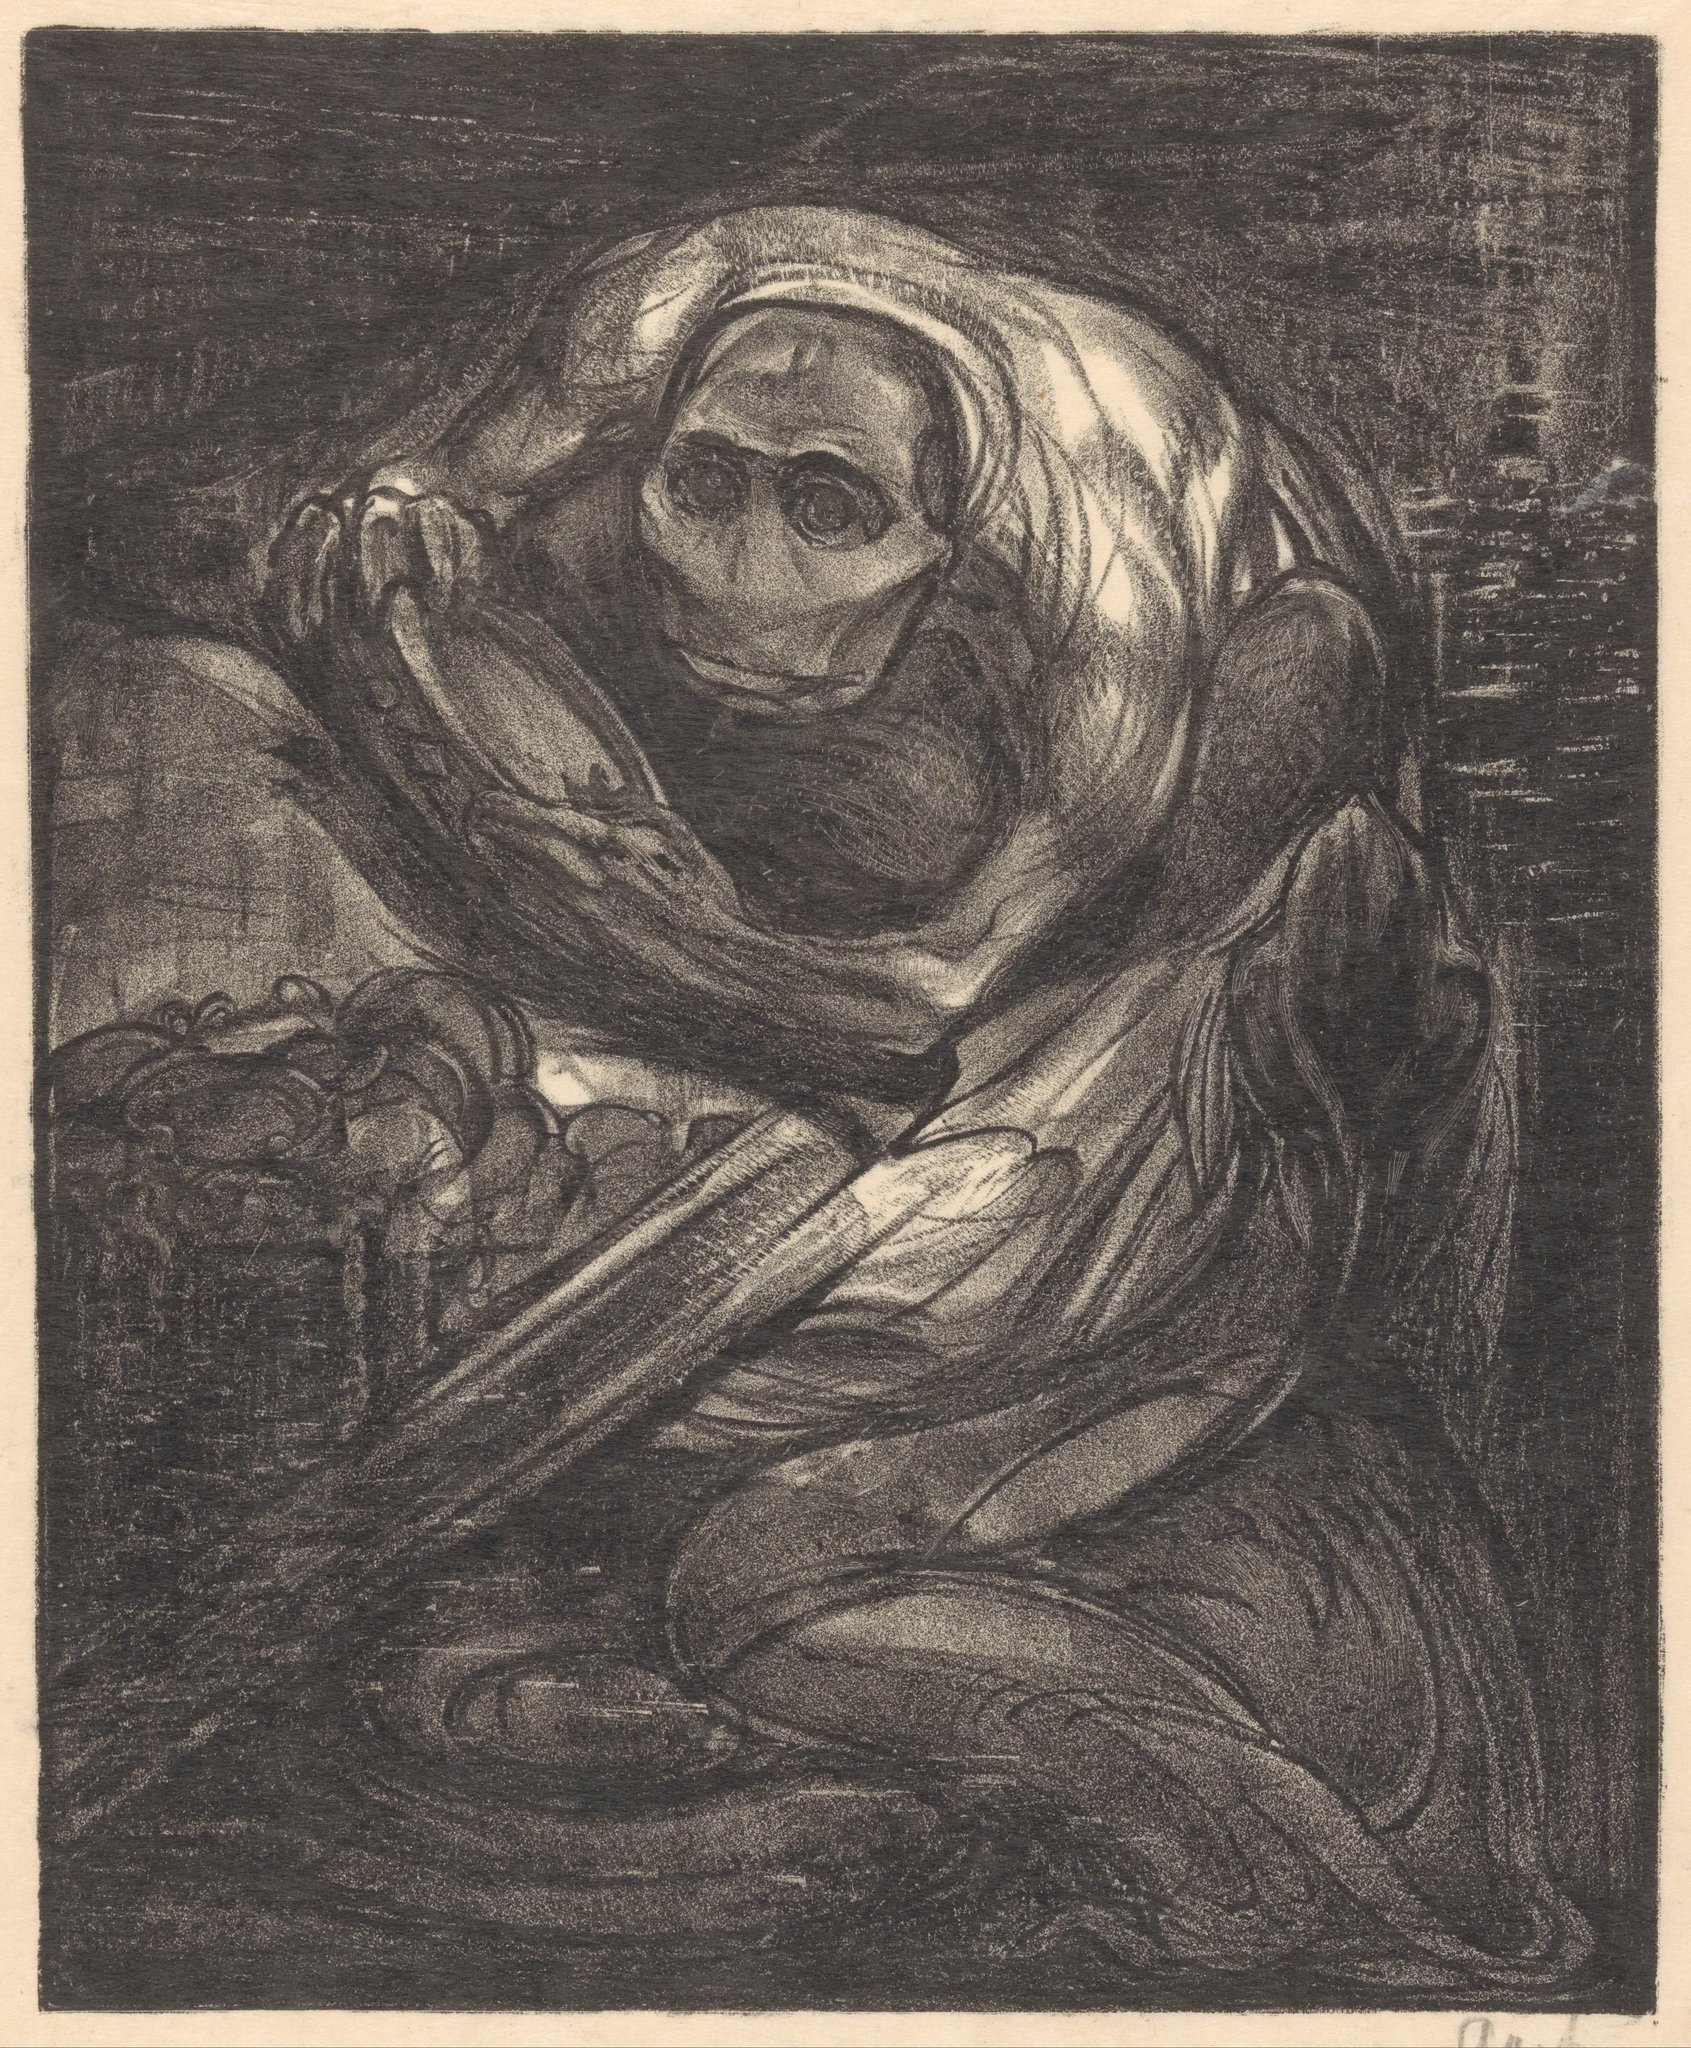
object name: print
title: Monster met schaal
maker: johannes josephus aarts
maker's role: draughtsman, print maker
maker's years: 1871-1934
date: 1881-1934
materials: paper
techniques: lithograph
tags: bowl, surrealia, surrealistic representations, mis-shapen animals; monsters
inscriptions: collector's mark: Lugt 2228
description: Een naakt, atletisch monster met een schaal in zijn hand. Links van hem meerdere schalen met handvatten. Rondom hem de schittering van water.